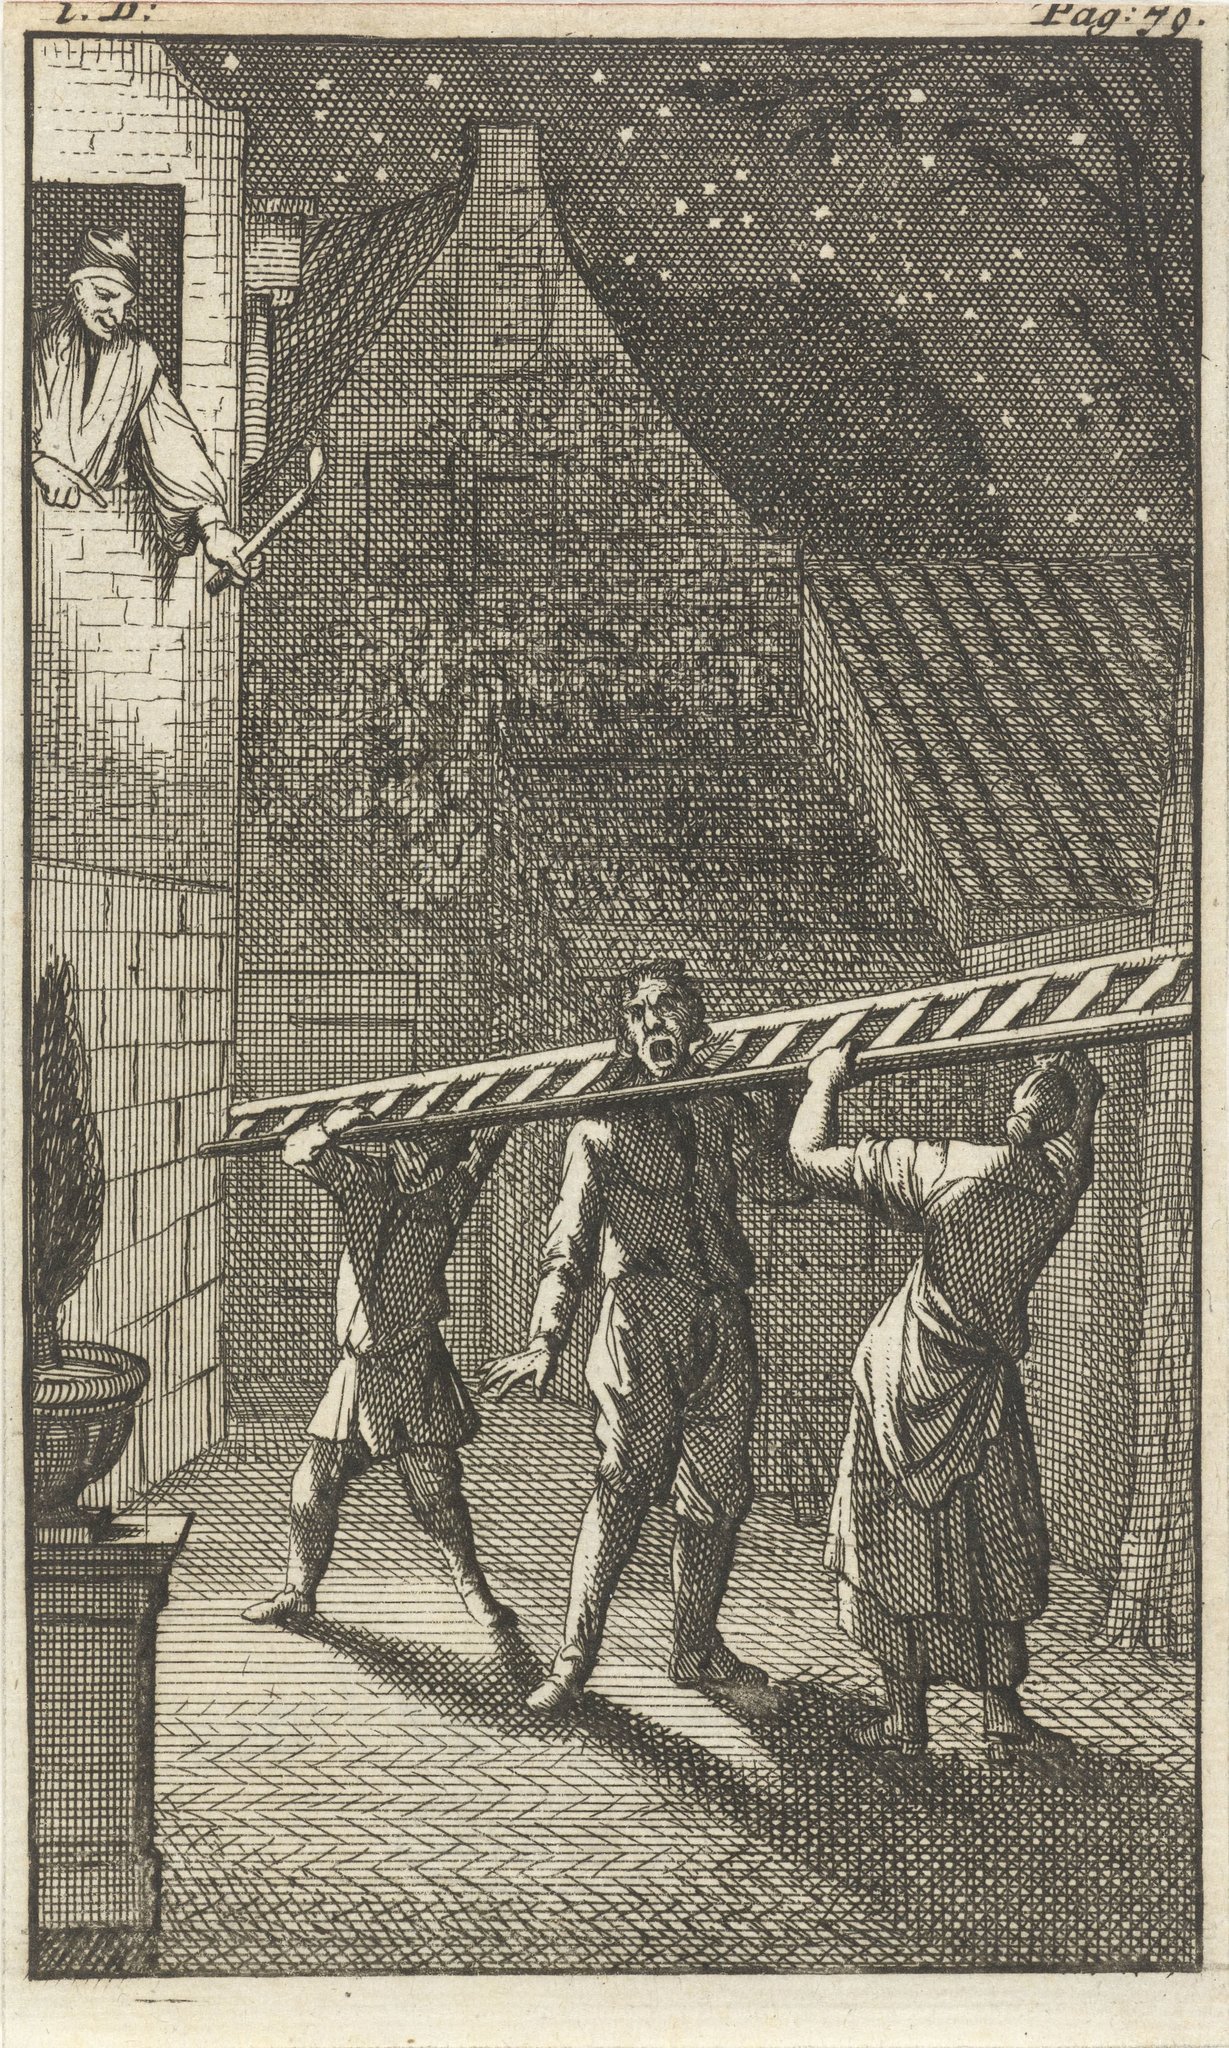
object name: print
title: Mirandors meester, de advocaat, met het hoofd verward in de sporten van een brandladder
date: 1695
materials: paper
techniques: etching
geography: amsterdam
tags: ladder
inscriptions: collector's mark: Lugt 2228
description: Illustratie uit: Heinsius, Nicolaas jr. Den vermakelyken avanturier, ofte De wispelturige, en niet min wonderlyke levens-loop van Mirandor, 2 delen. Amsterdam: Pieter van Amsterdam, 1695, dl. I.